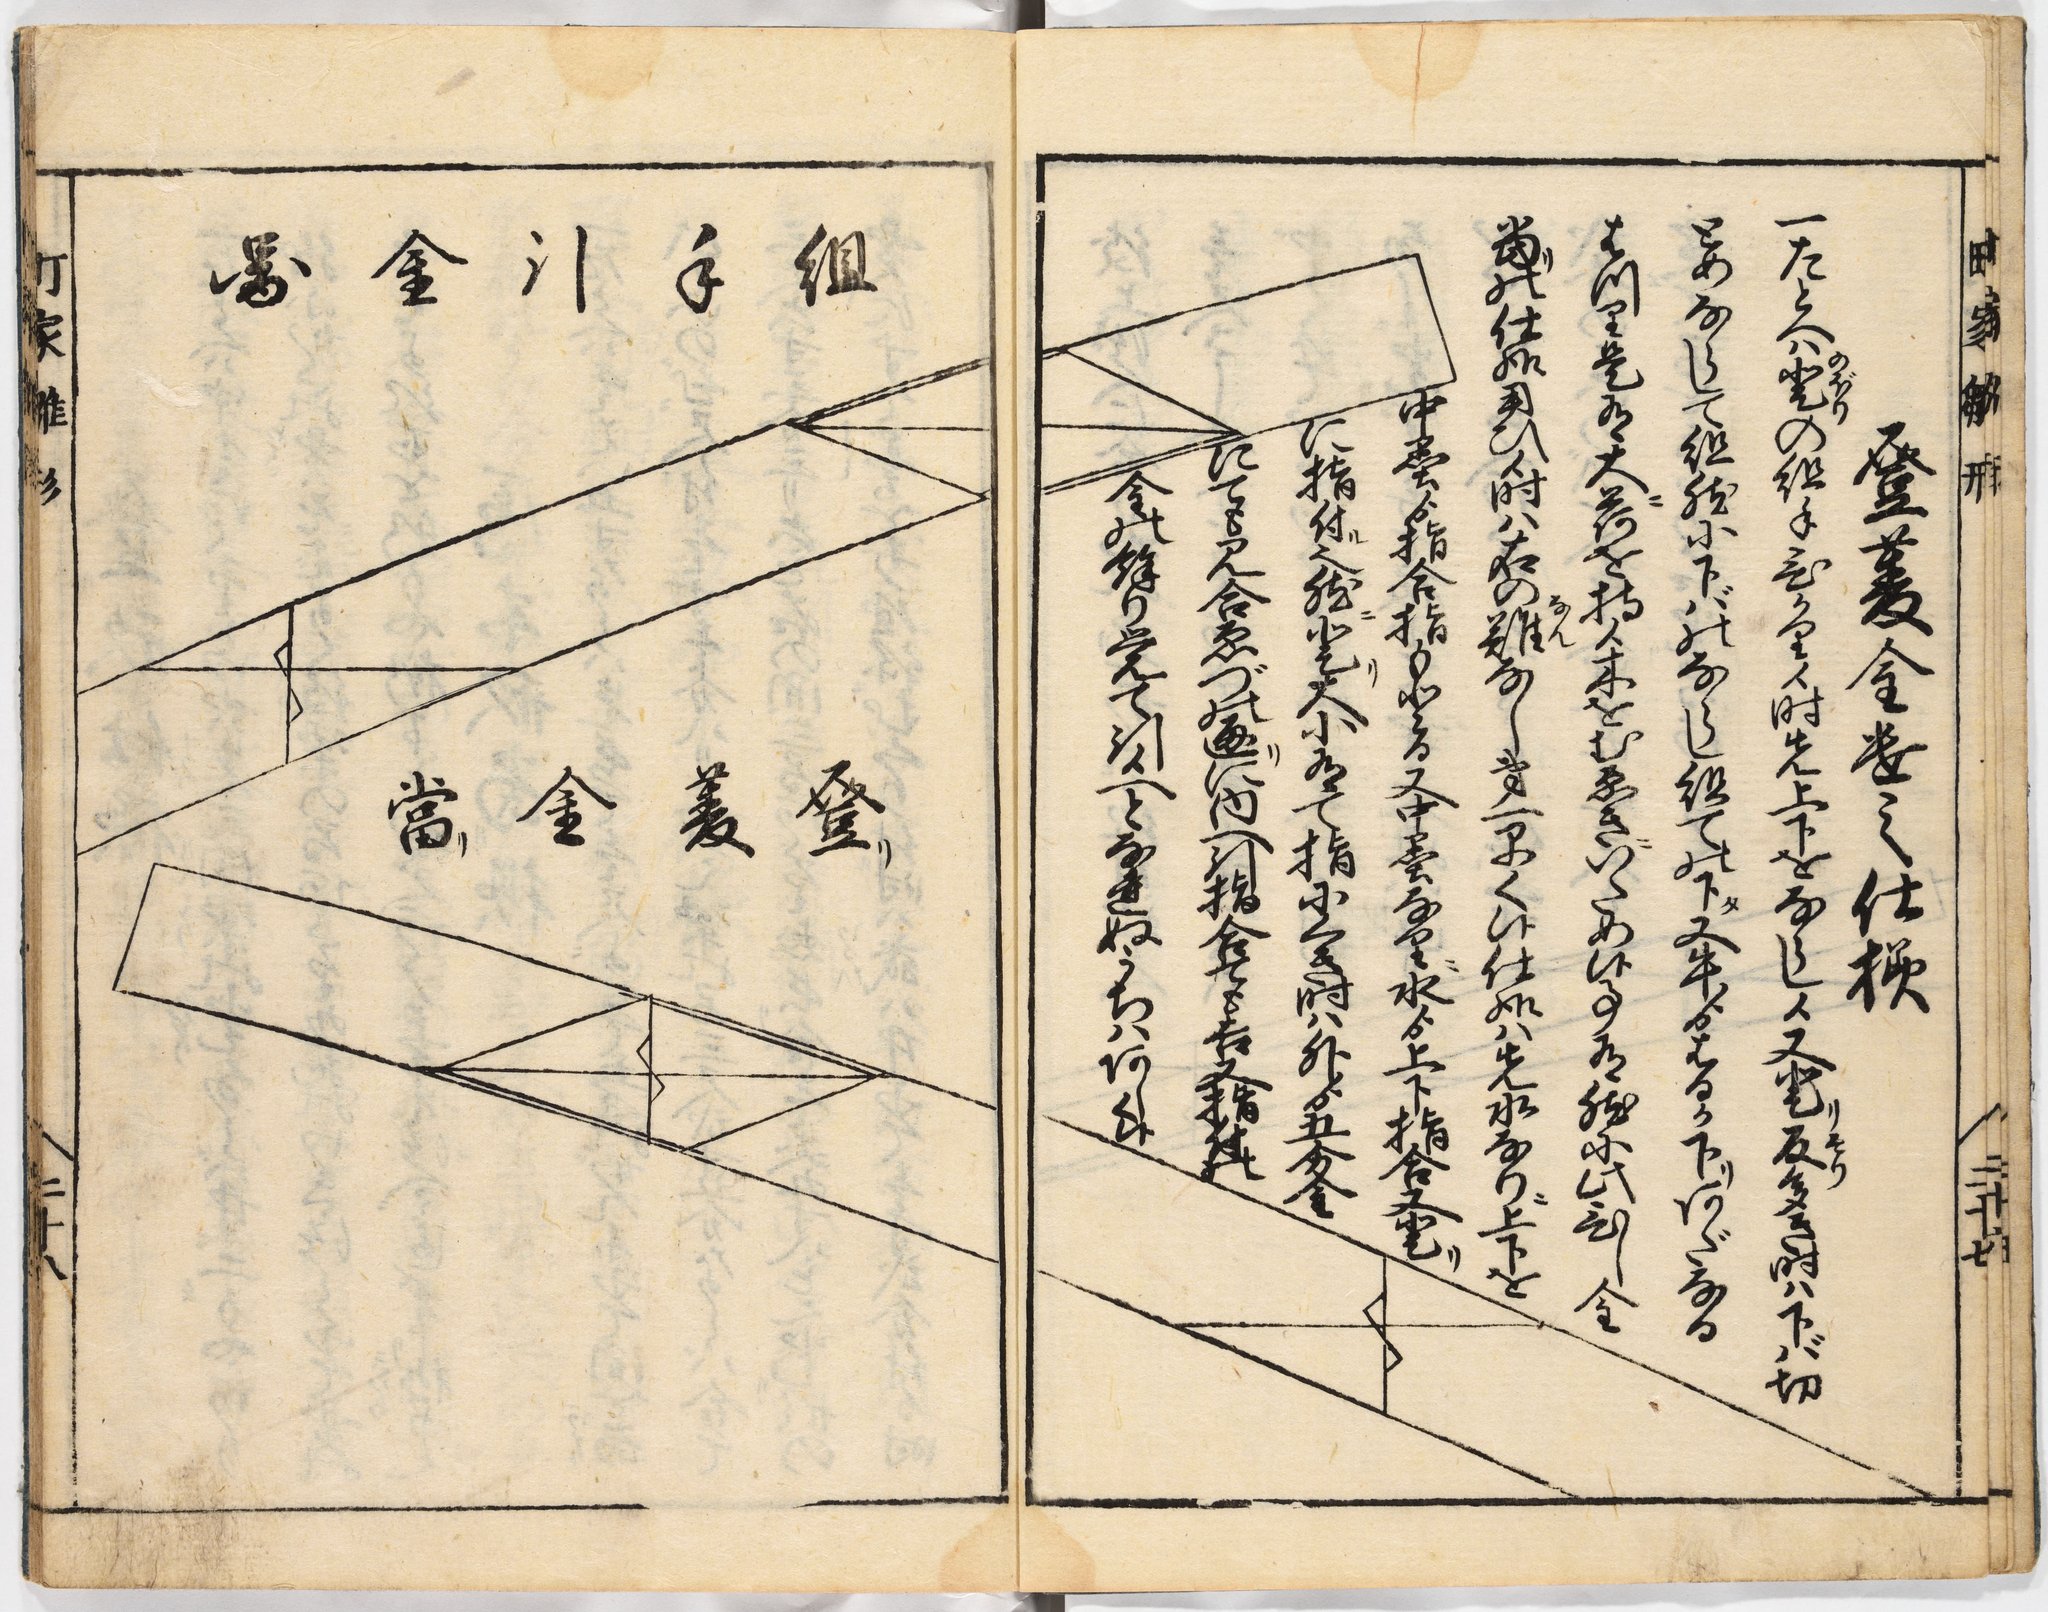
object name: illustrated book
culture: japanese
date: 1893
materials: ink, paper